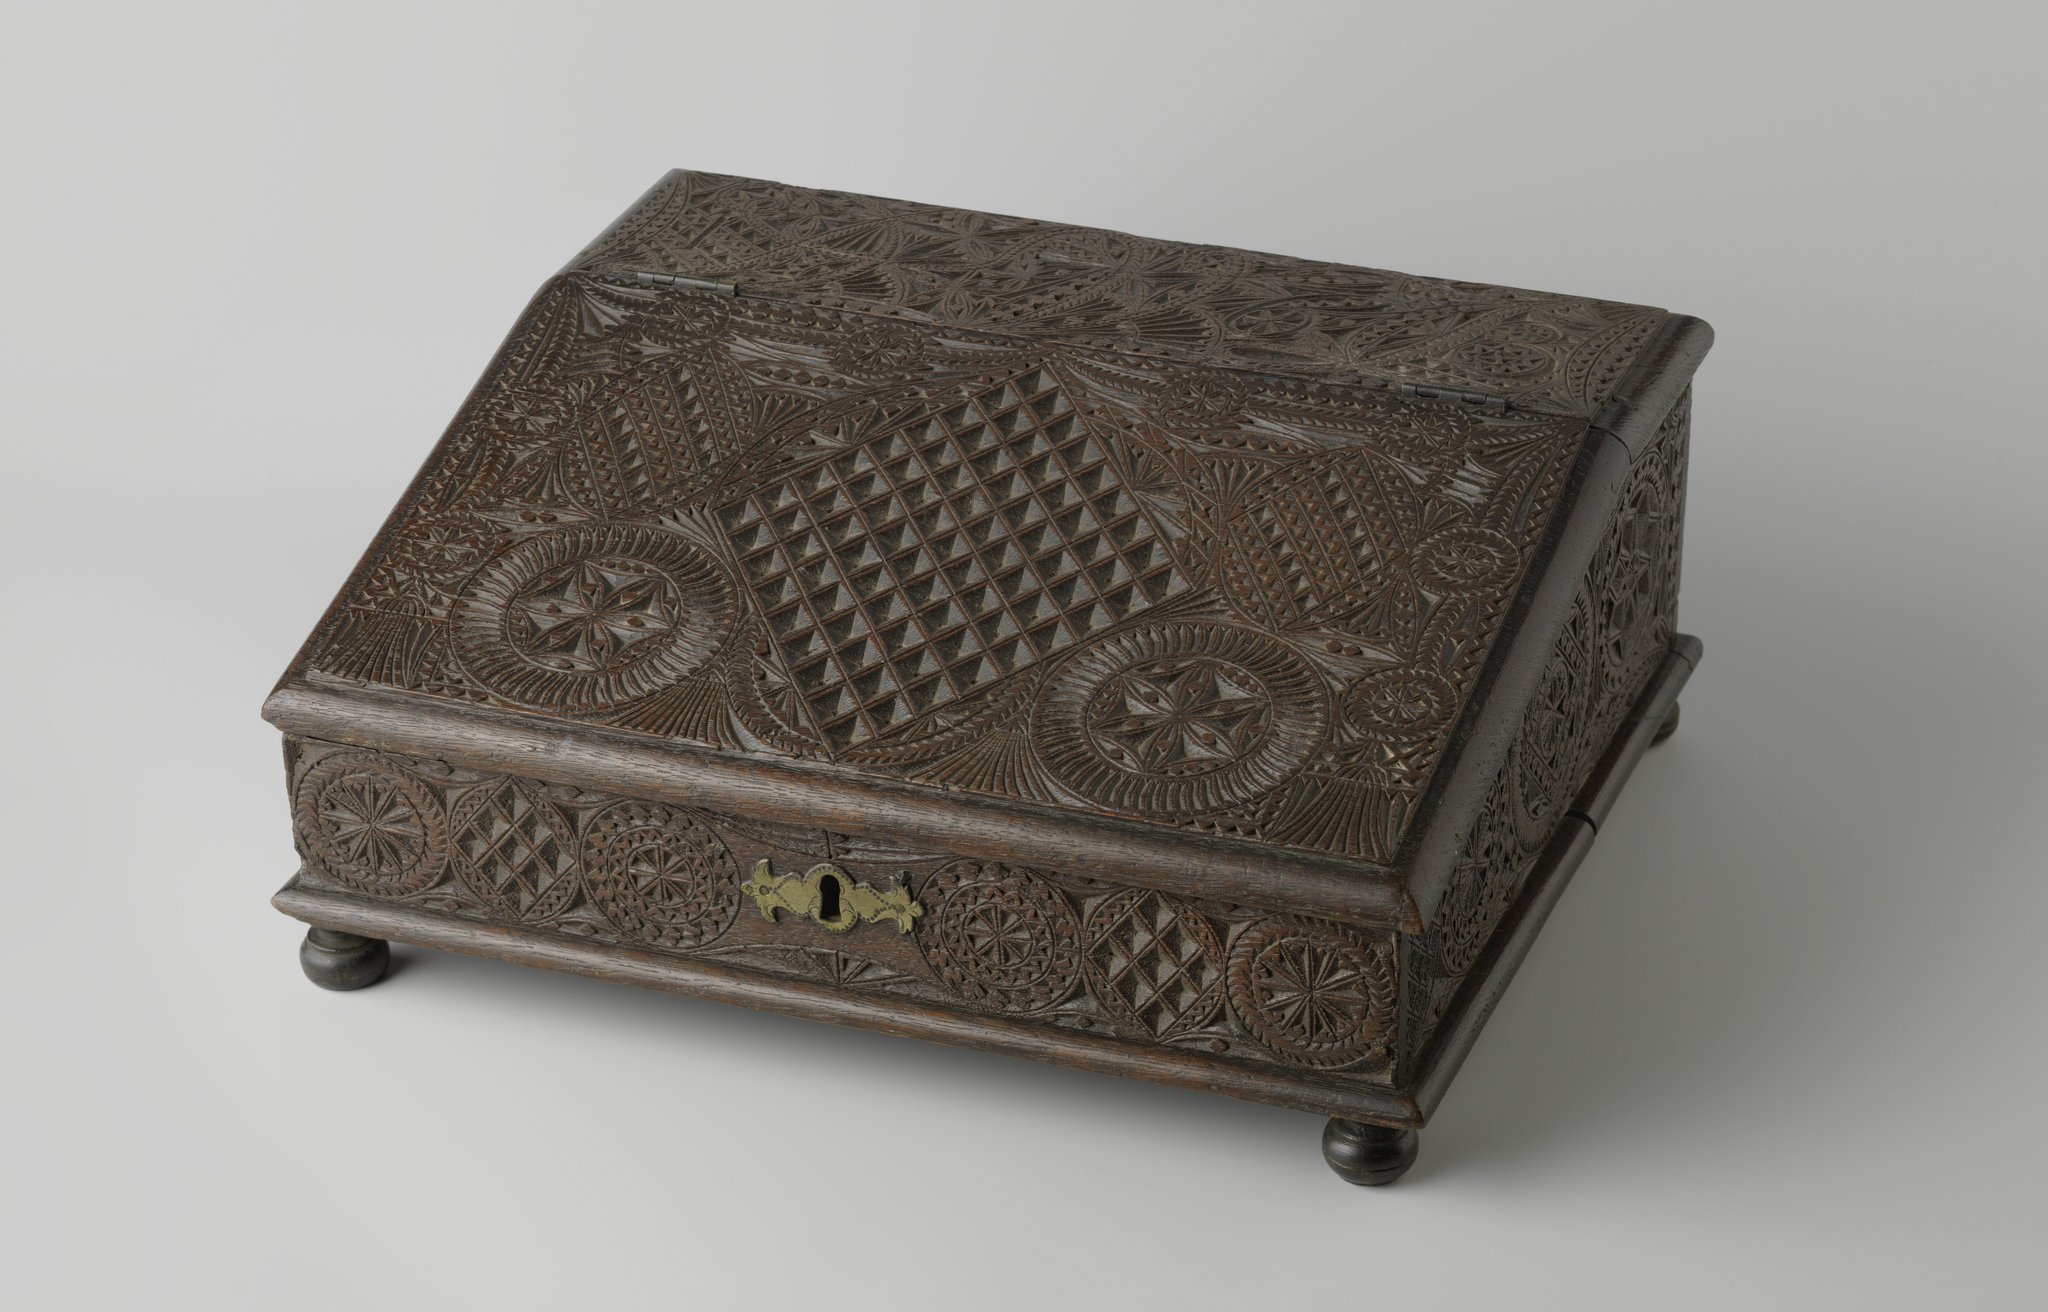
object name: schrijfkist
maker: Anonymous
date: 1400-1950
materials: wood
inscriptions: initials: ‘G d L’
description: Schrijfkist, versierd met gesneden bladmotieven en ruitmotief op het deksel op vier ronde pootjes. Vergulde slotplaat (sleutel ontbreekt). De binnenkant van de kist bevat vier laden met koperen (?) knoppen. Op binnenkant deksel de initialen G d L.